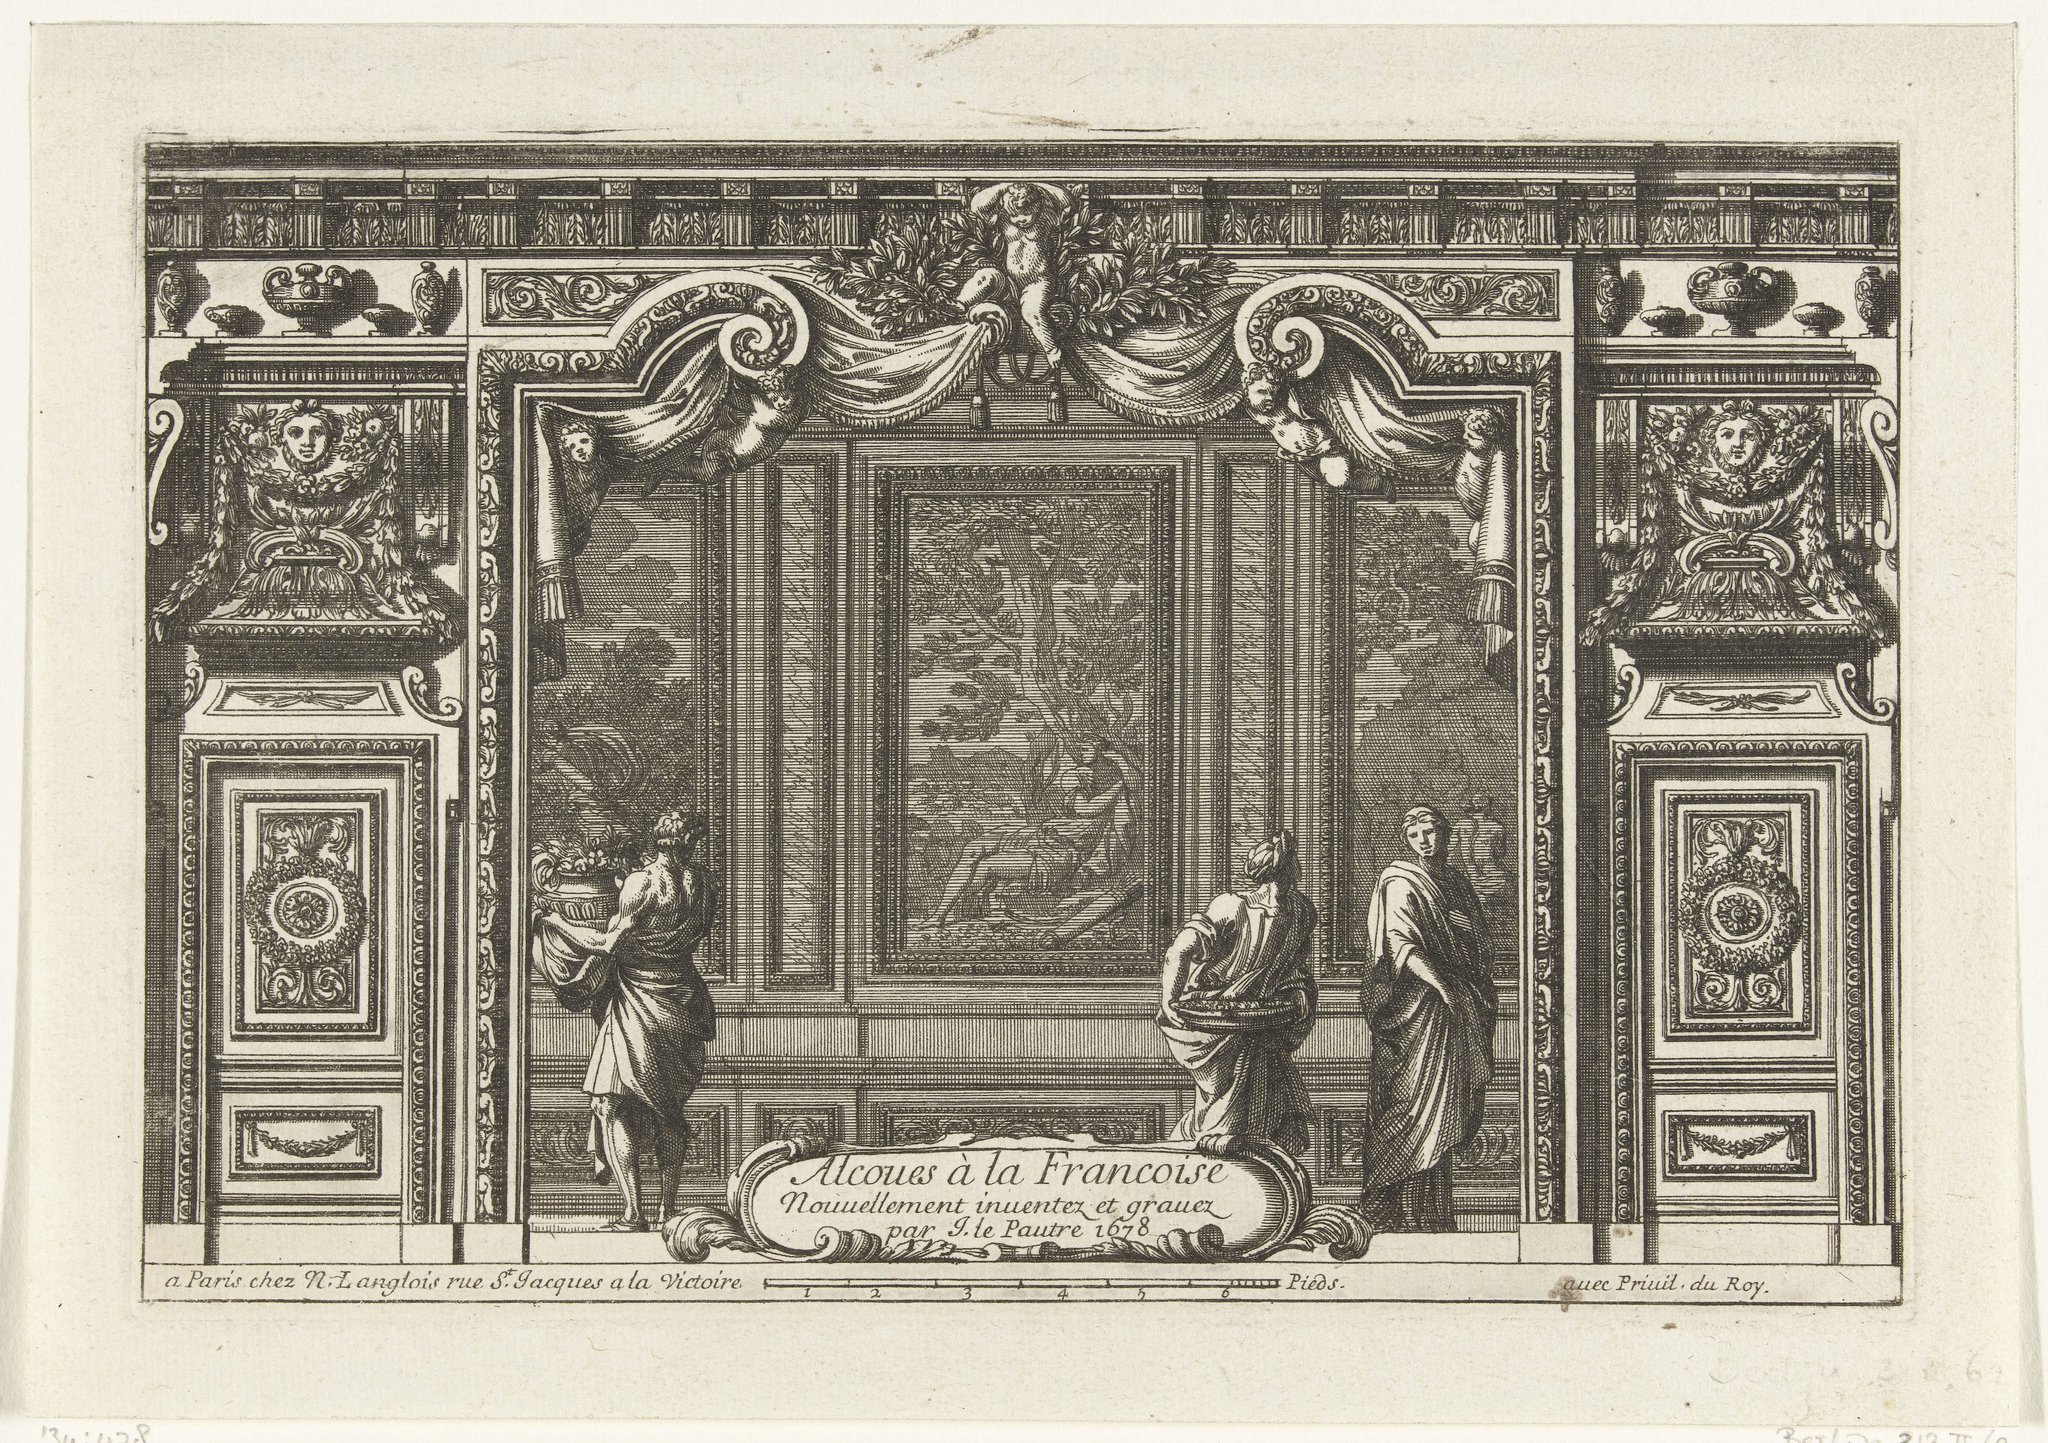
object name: titelblad, titelpagina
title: Alcoves à la Francoise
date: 1678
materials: paper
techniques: etching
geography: france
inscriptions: date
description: Alkoof, waarvan de achterste muur gedecoreerd is met schilderijen. Titelblad uit serie van 6 bladen.